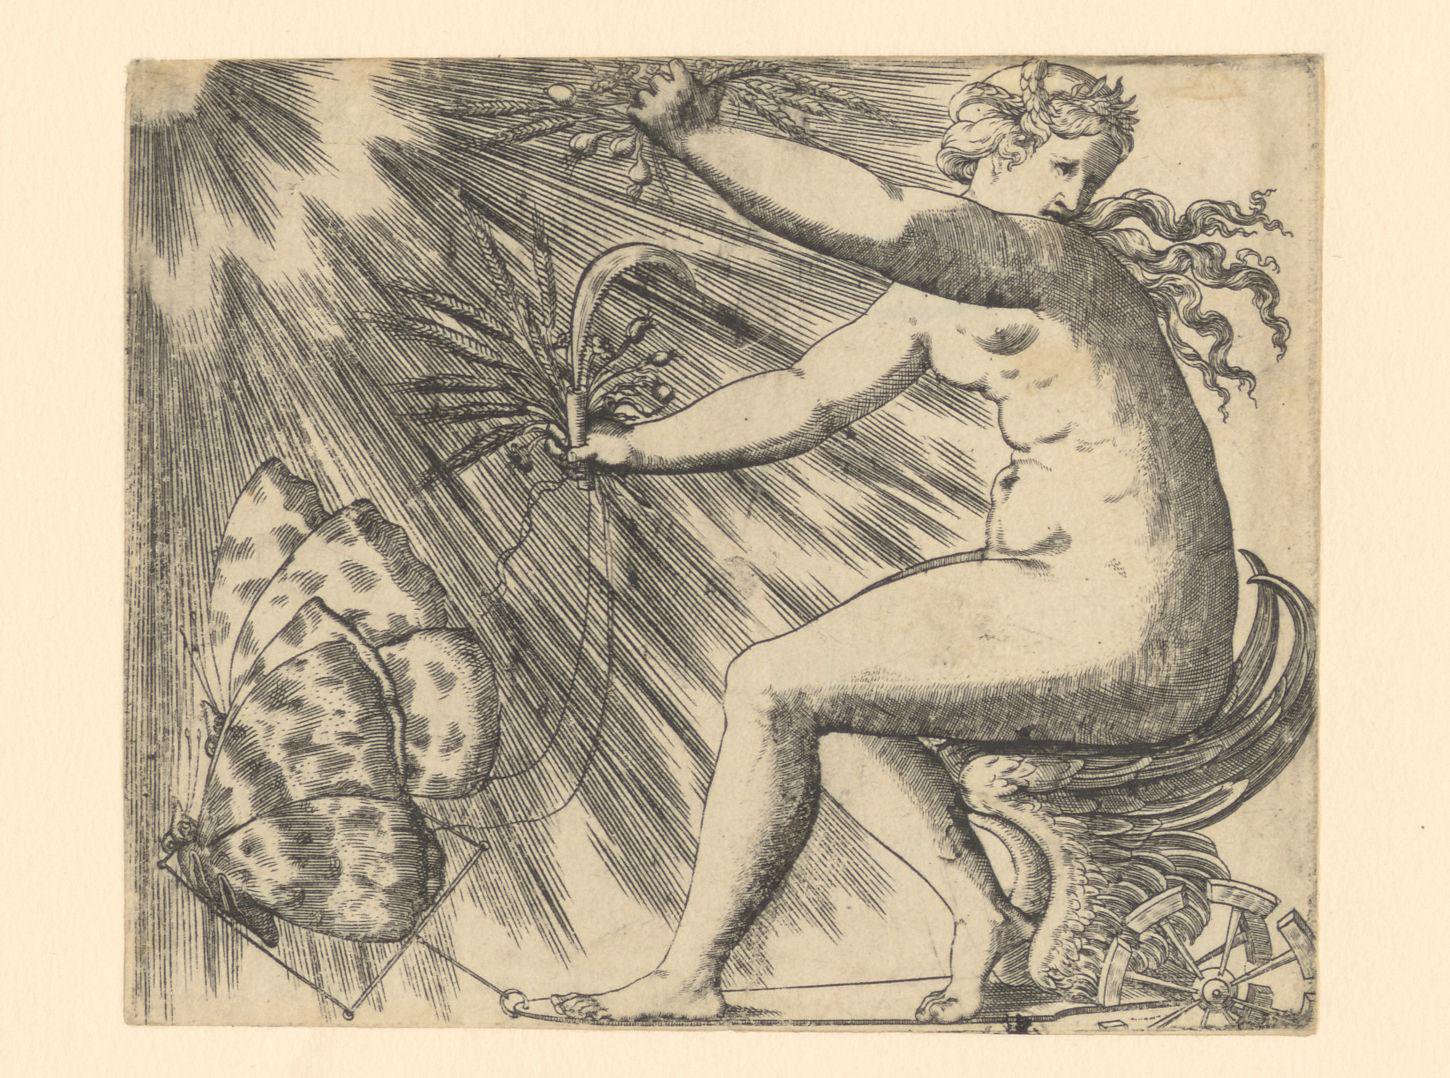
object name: print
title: Ceres op een strijdwagen getrokken door vlinders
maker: johann ladenspelder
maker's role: artist, painter, print maker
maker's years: 1512-1561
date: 1522-1561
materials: paper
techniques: engraving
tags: (story of) ceres (demeter), insects: butterfly, agricultural implements: sickle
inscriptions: collector's mark: Lugt 2228